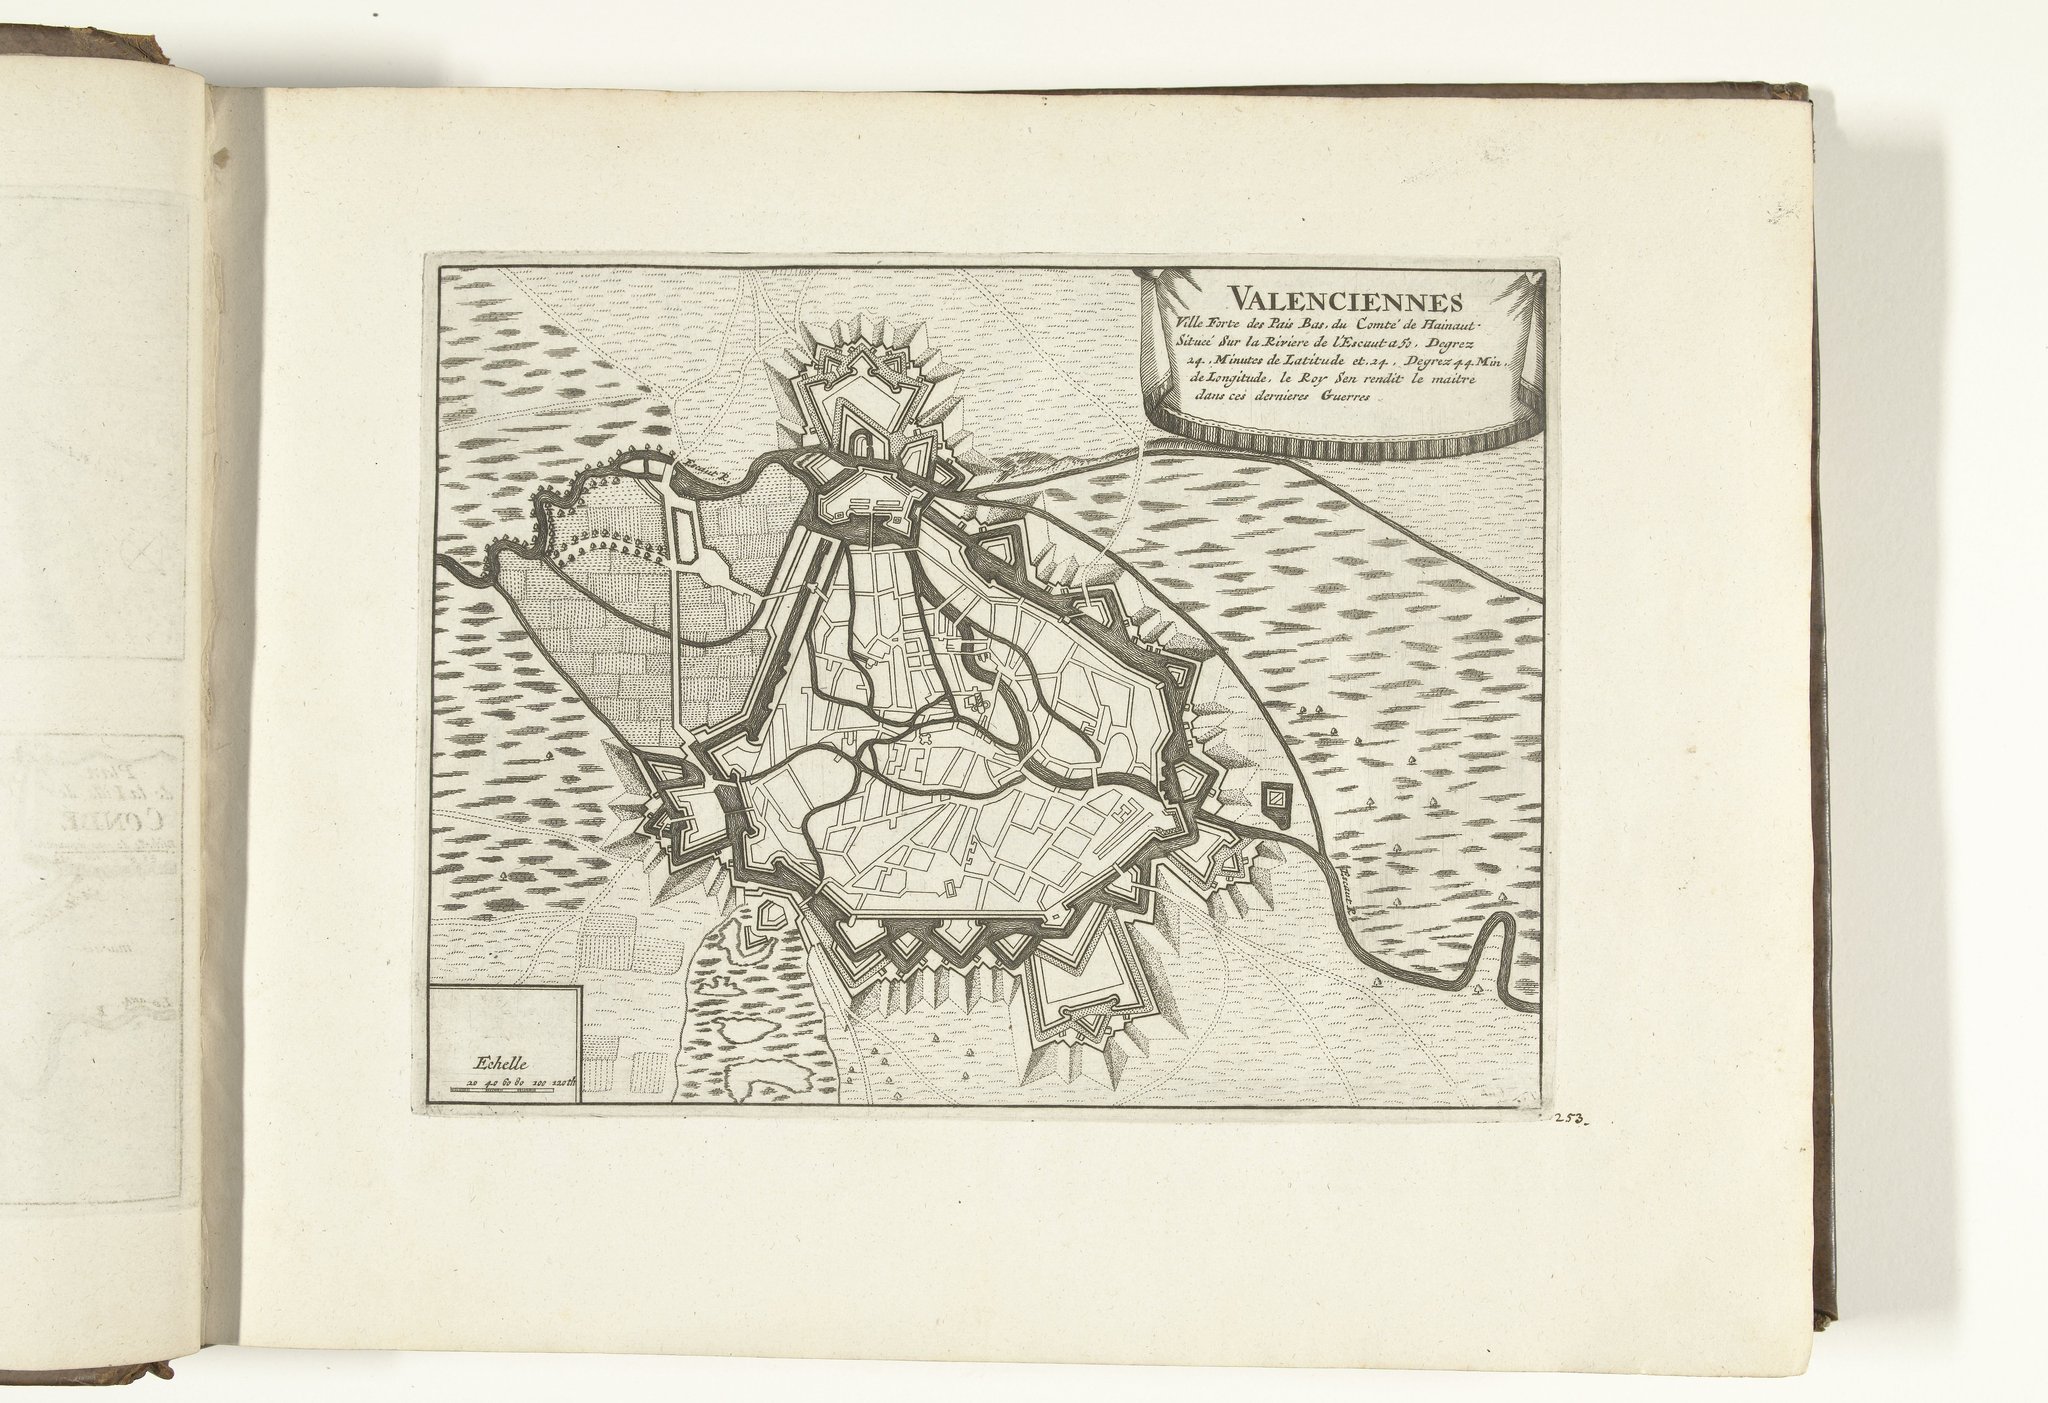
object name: print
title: Valenciennes Ville Forte des Pais Bas, du Comté de Hainaut (...)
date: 1726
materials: paper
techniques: etching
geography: northern netherlands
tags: fortress, maps of cities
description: Plattegrond van de versterkingen om de stad Valenciennes. Plaat nr. 253 in deel XI van het prentwerk: Les Forces de l'Europe, Asie, Afrique et Amerique ... Comme aussi les Cartes des Côtes de France et d'Espagne uit 1726, dit tweede deel met 271 met de hand genummerde platen van vermaarde sterke steden en vestingen in het kader van de Spaanse Successieoorlog 1701-1713. Voor het merendeel zijn deze platen gekopieerd naar de anonieme Franse platen van vermaarde sterke steden en vestingen: in Les forces de l'Europe en in: Le theatre de la guerre, dans les Pays-Bas, beide oorspronkelijk uitgegeven door Nicolas de Fer te Parijs (1693-1697) in het kader van de Negenjarige Oorlog. Titel en opschriften in het Frans.